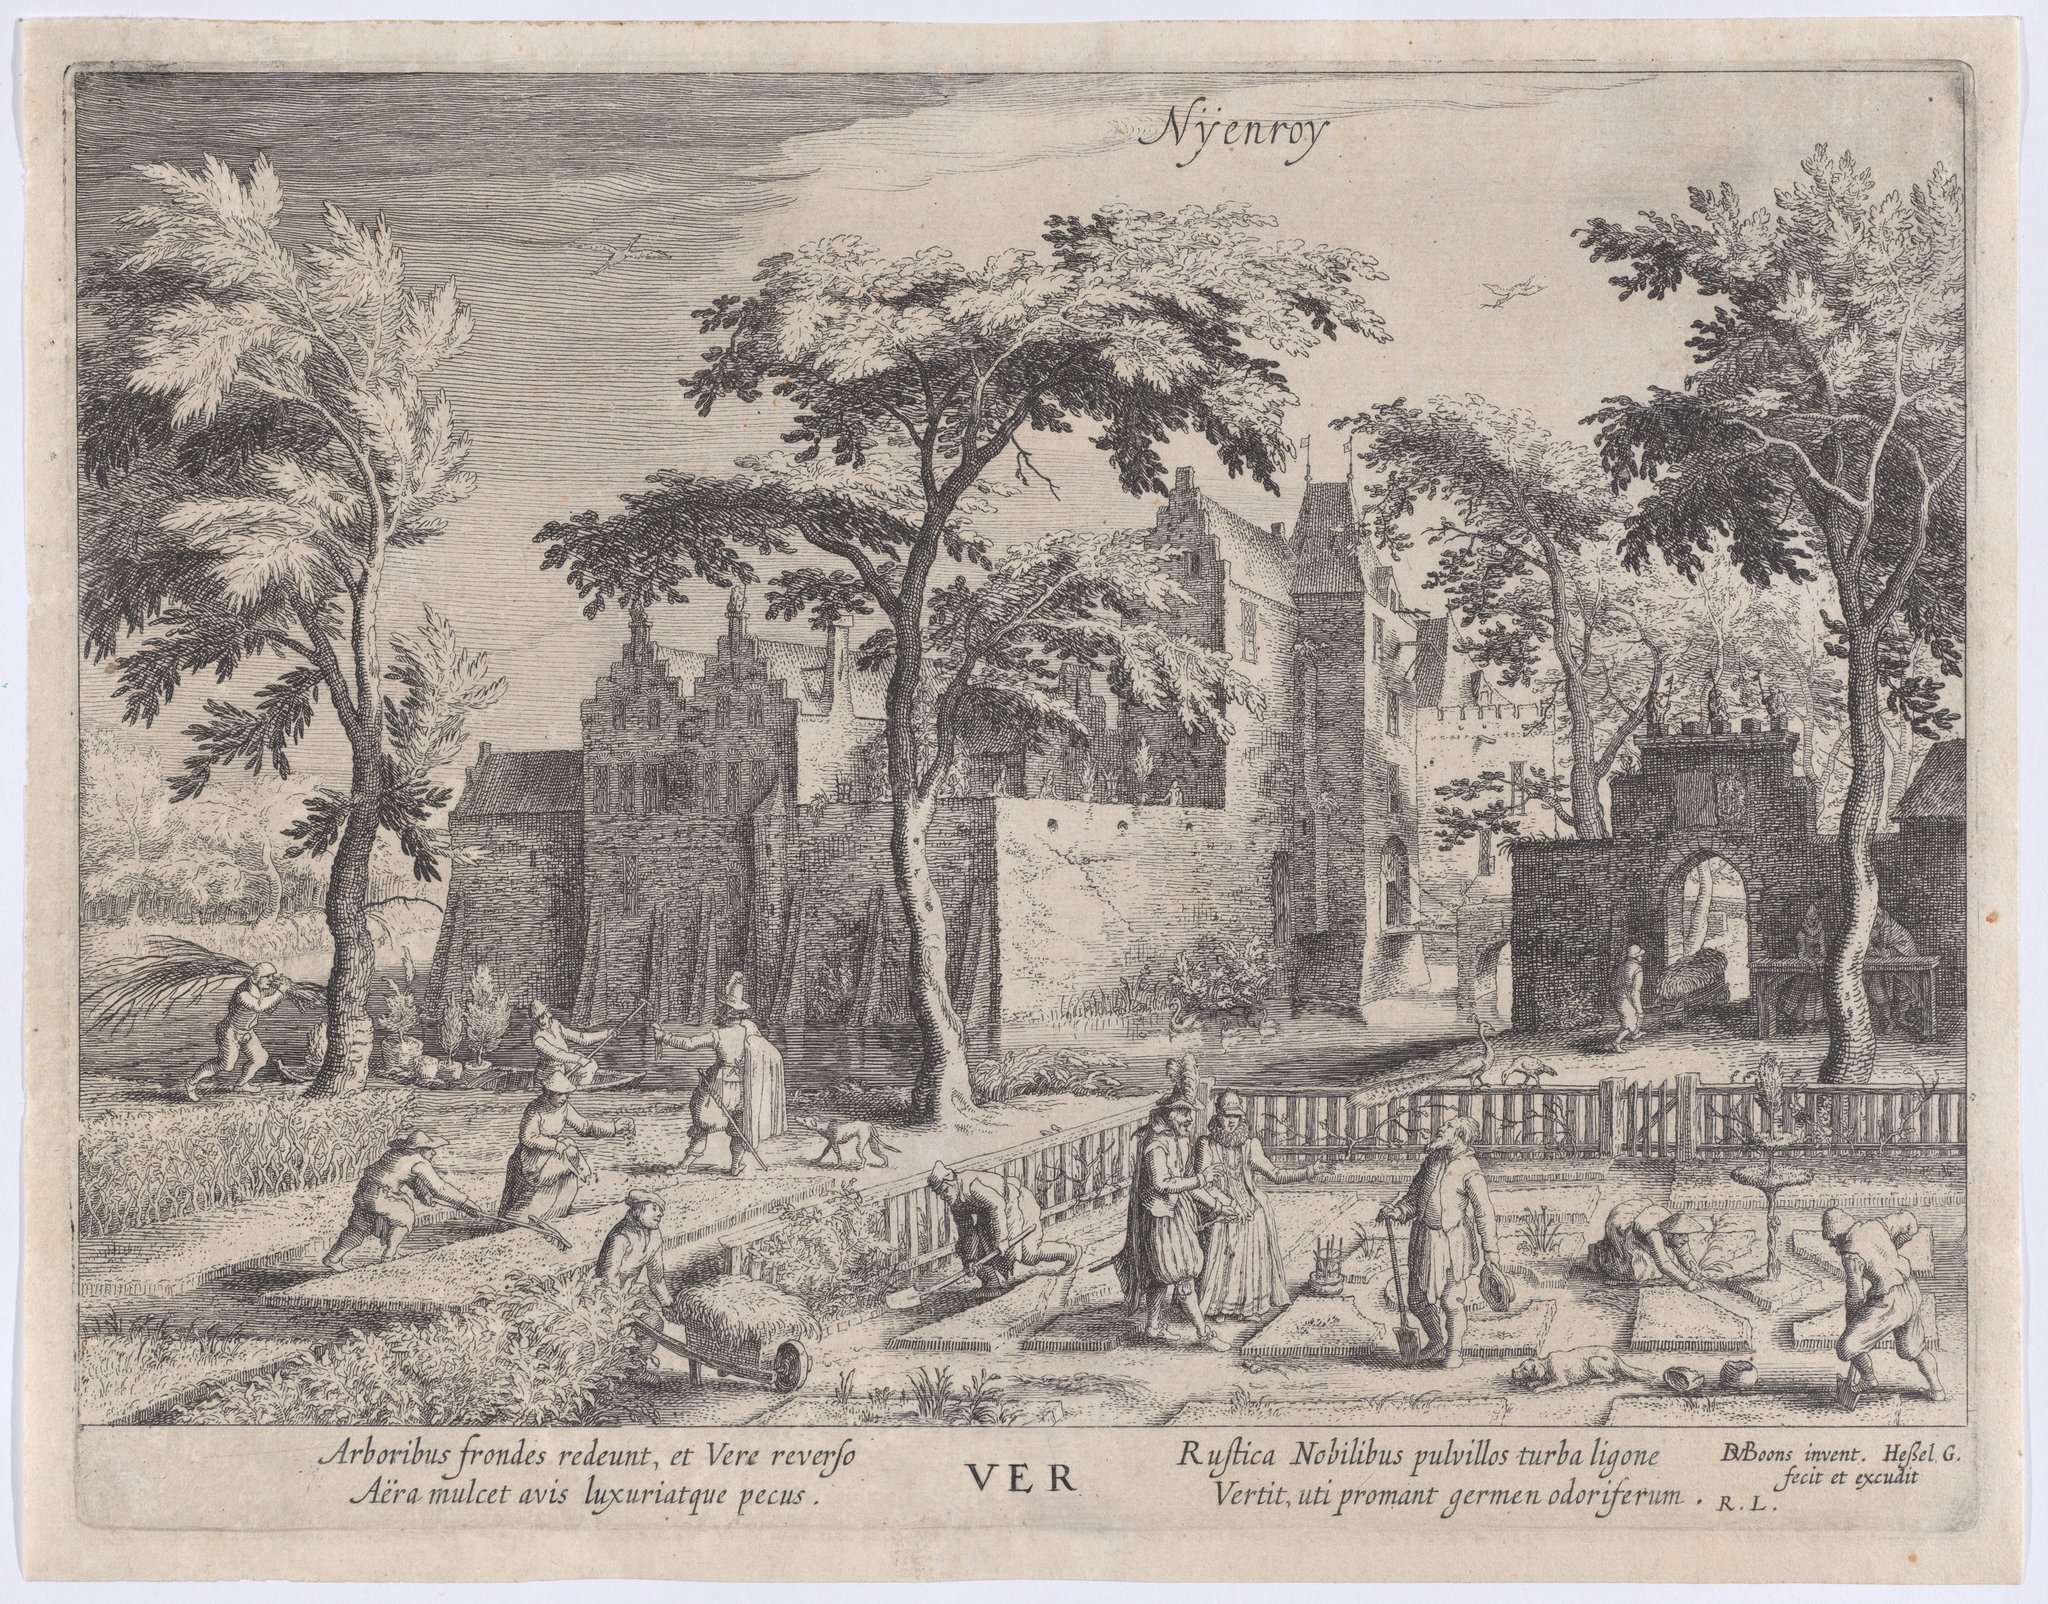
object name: print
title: Spring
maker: david vinckboons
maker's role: artist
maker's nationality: netherlandish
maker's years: 1576-1629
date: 1610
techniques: etching